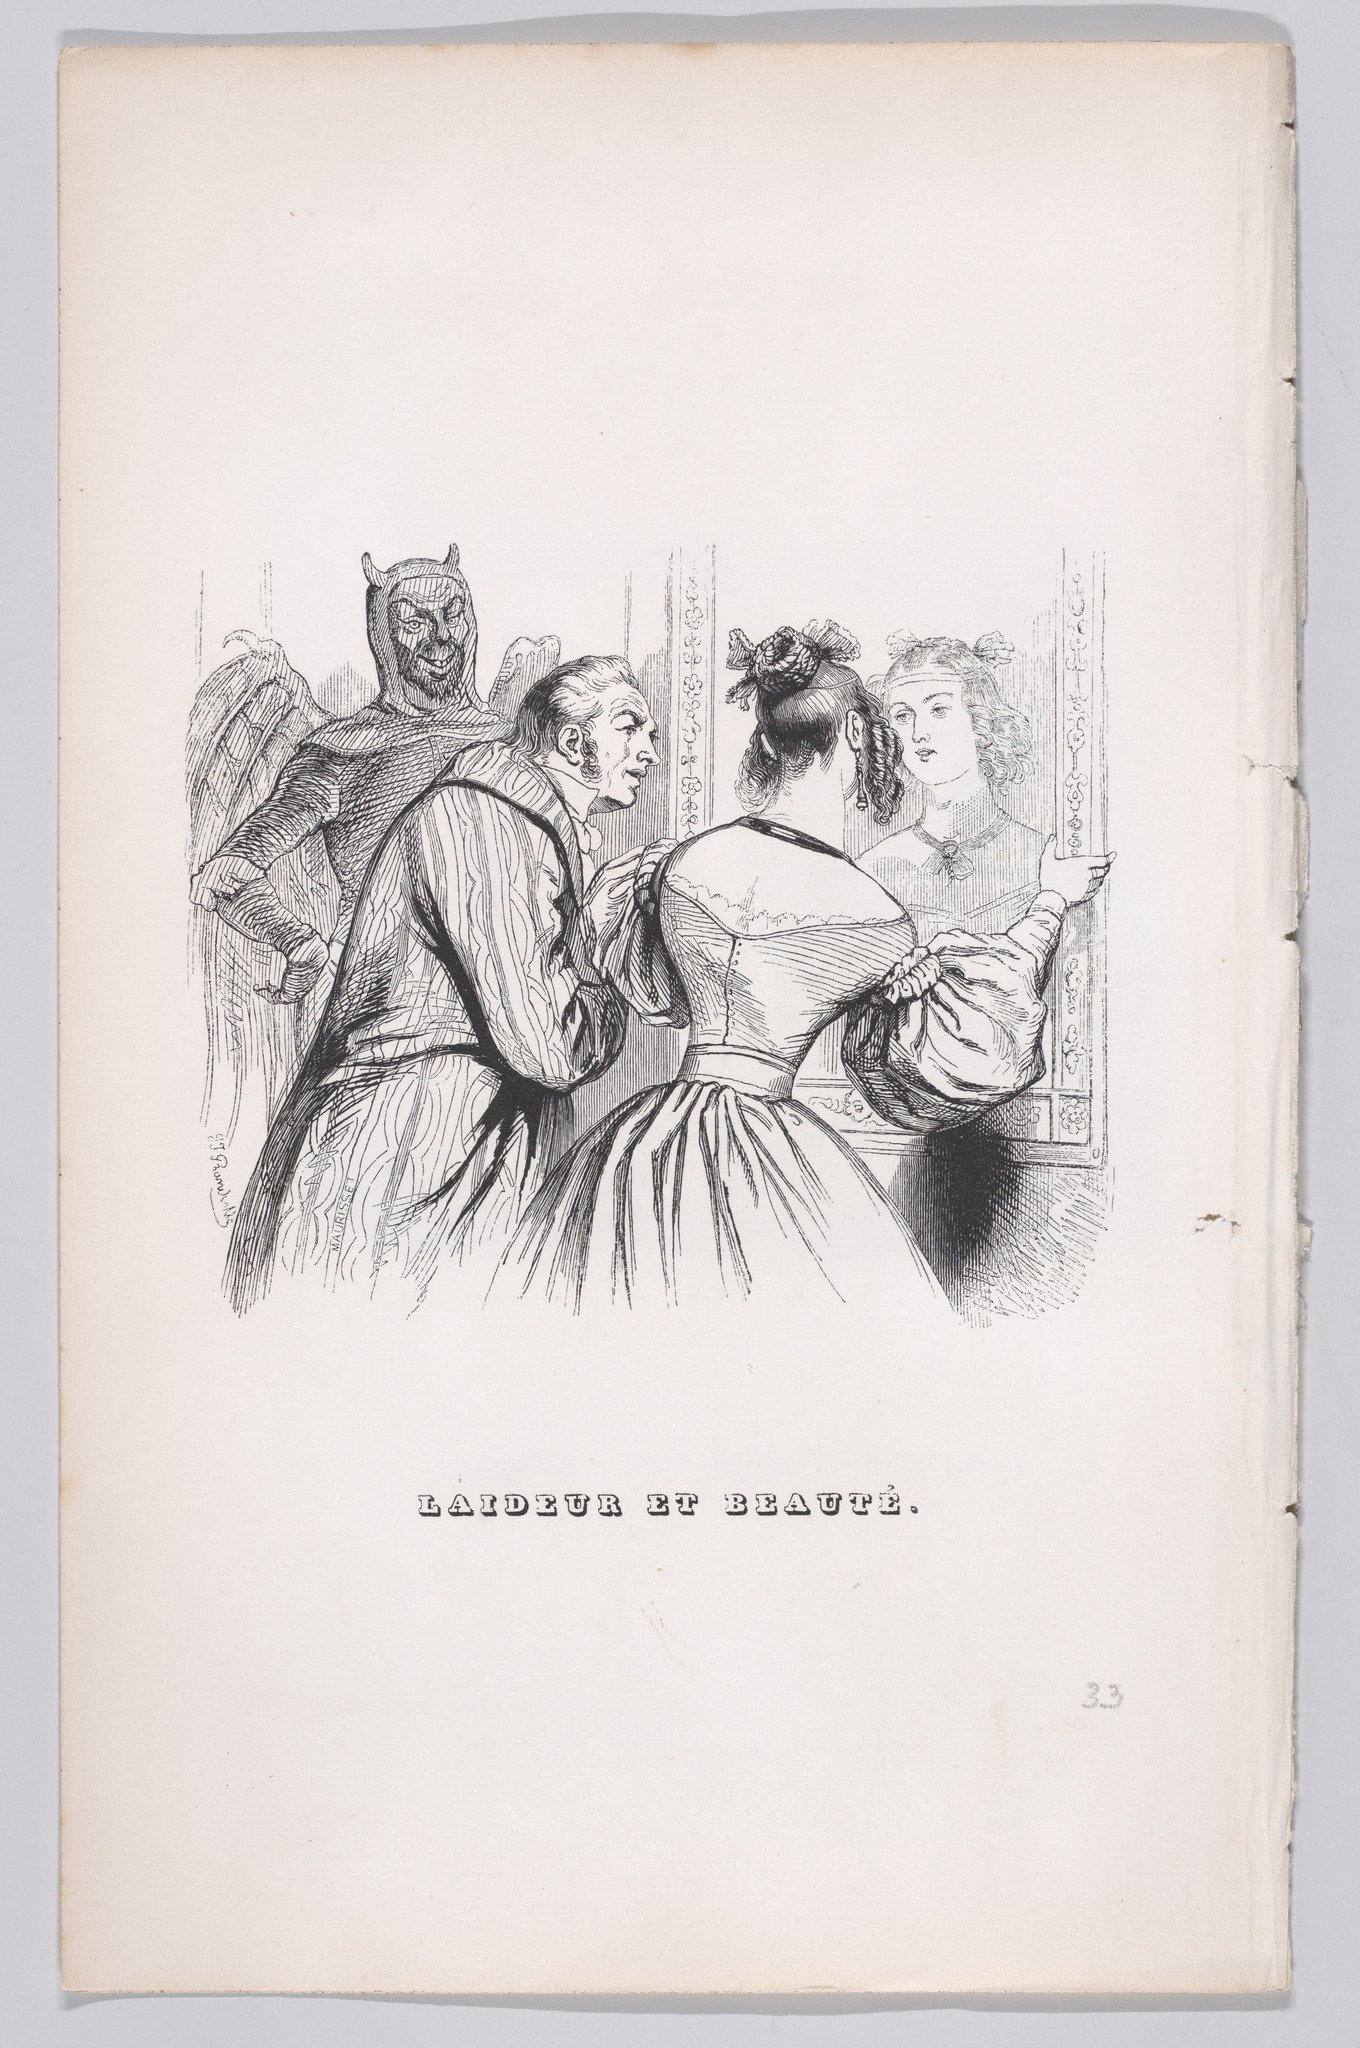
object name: print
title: Ugliness and Beauty, from "The Complete Works of Béranger"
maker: j. j. grandville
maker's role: illustrator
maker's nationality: french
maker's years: 1803-1847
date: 1836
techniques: engraving